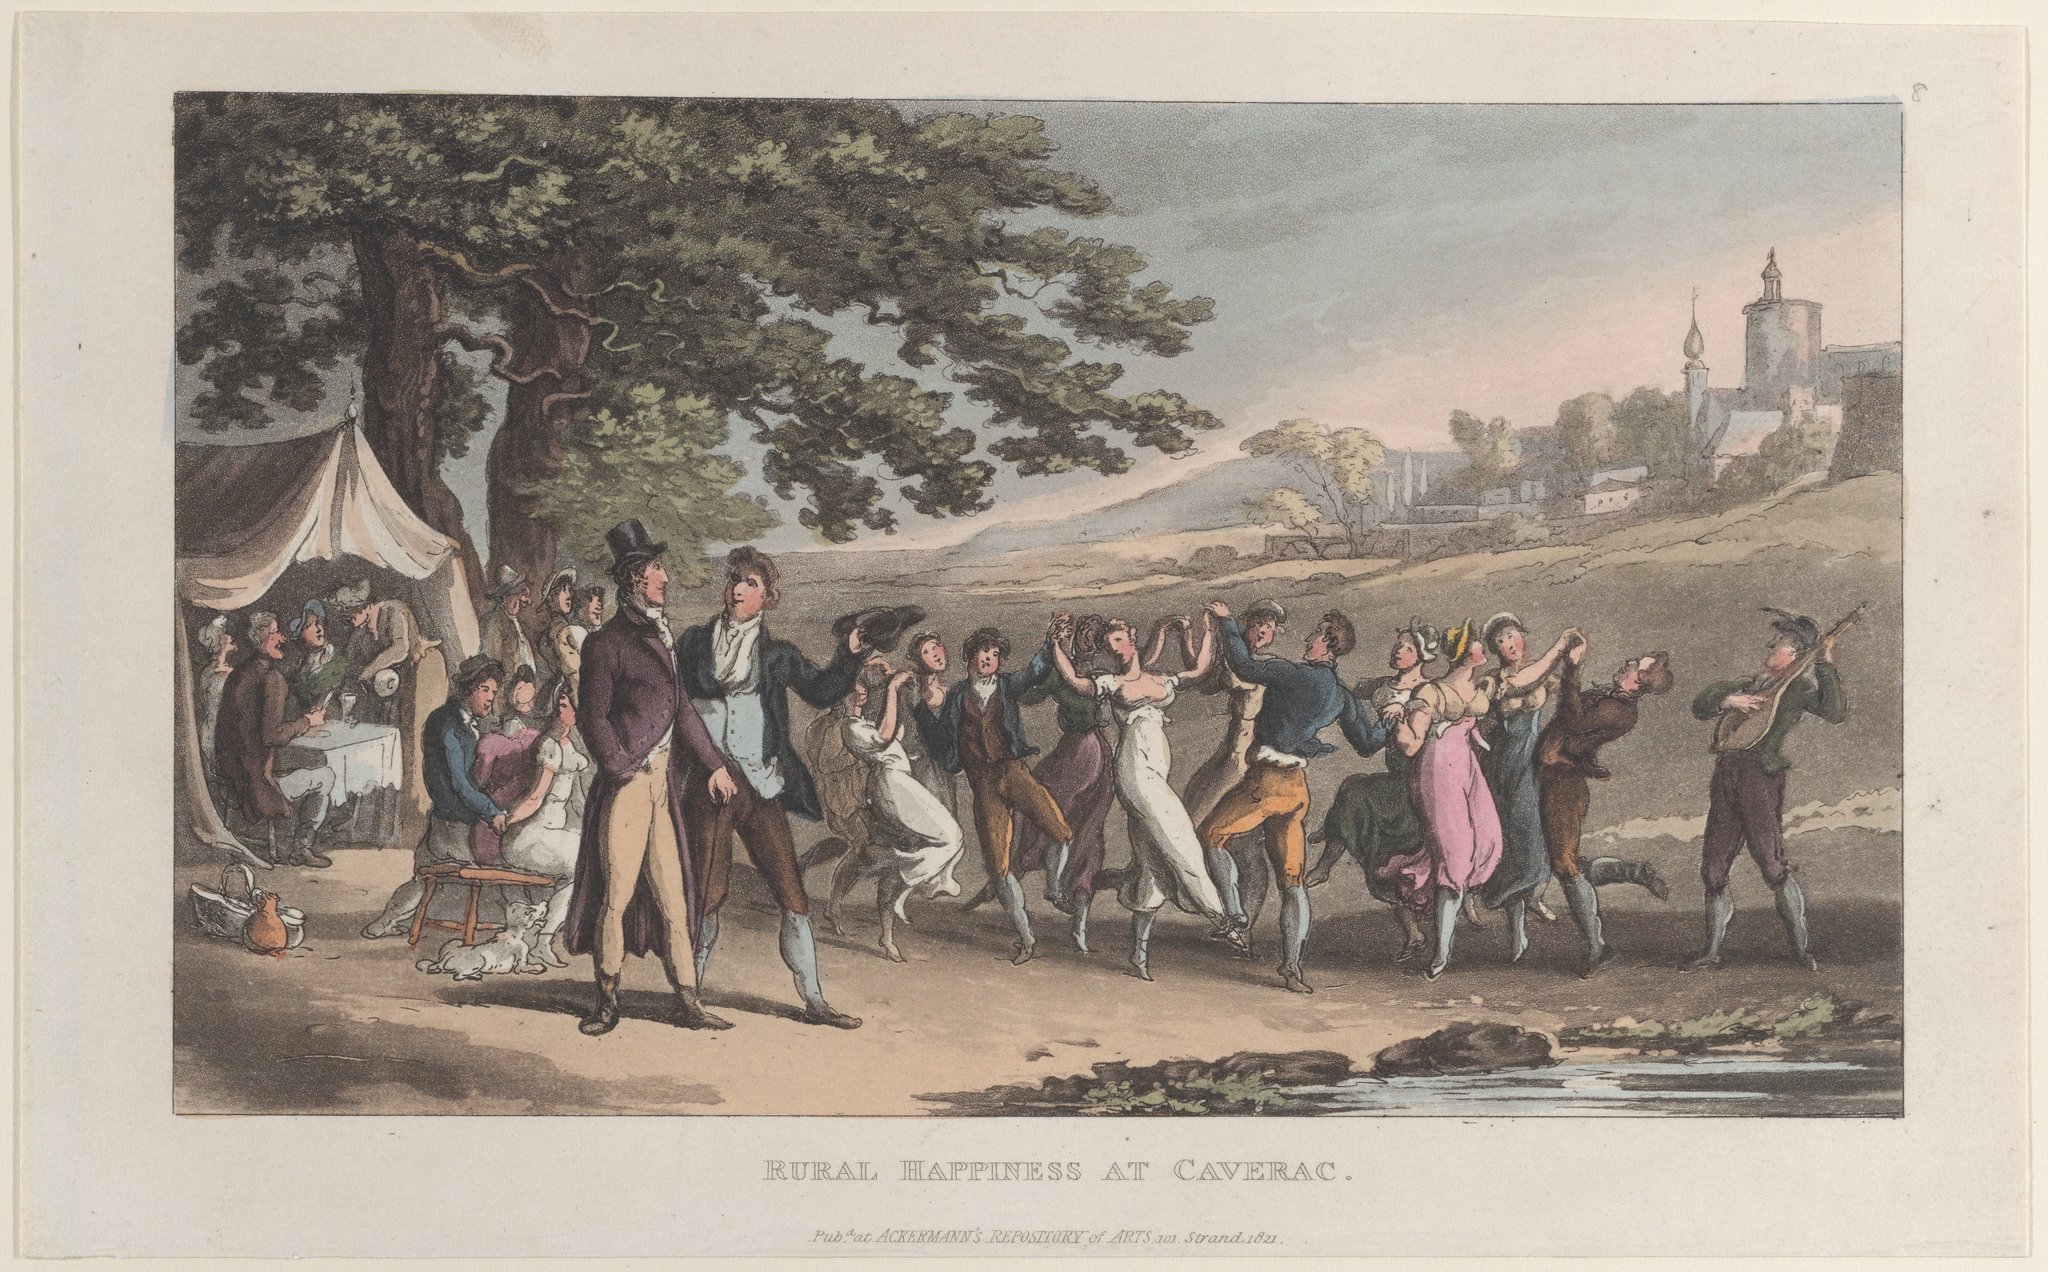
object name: print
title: Rural Happiness at Caverac, from "Journal of Sentimental Travels in the Southern Provinces of France, Shortly Before the Revolution"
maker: thomas rowlandson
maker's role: artist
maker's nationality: british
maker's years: 1757-1827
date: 1821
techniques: aquatint, etching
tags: men,women,dancing